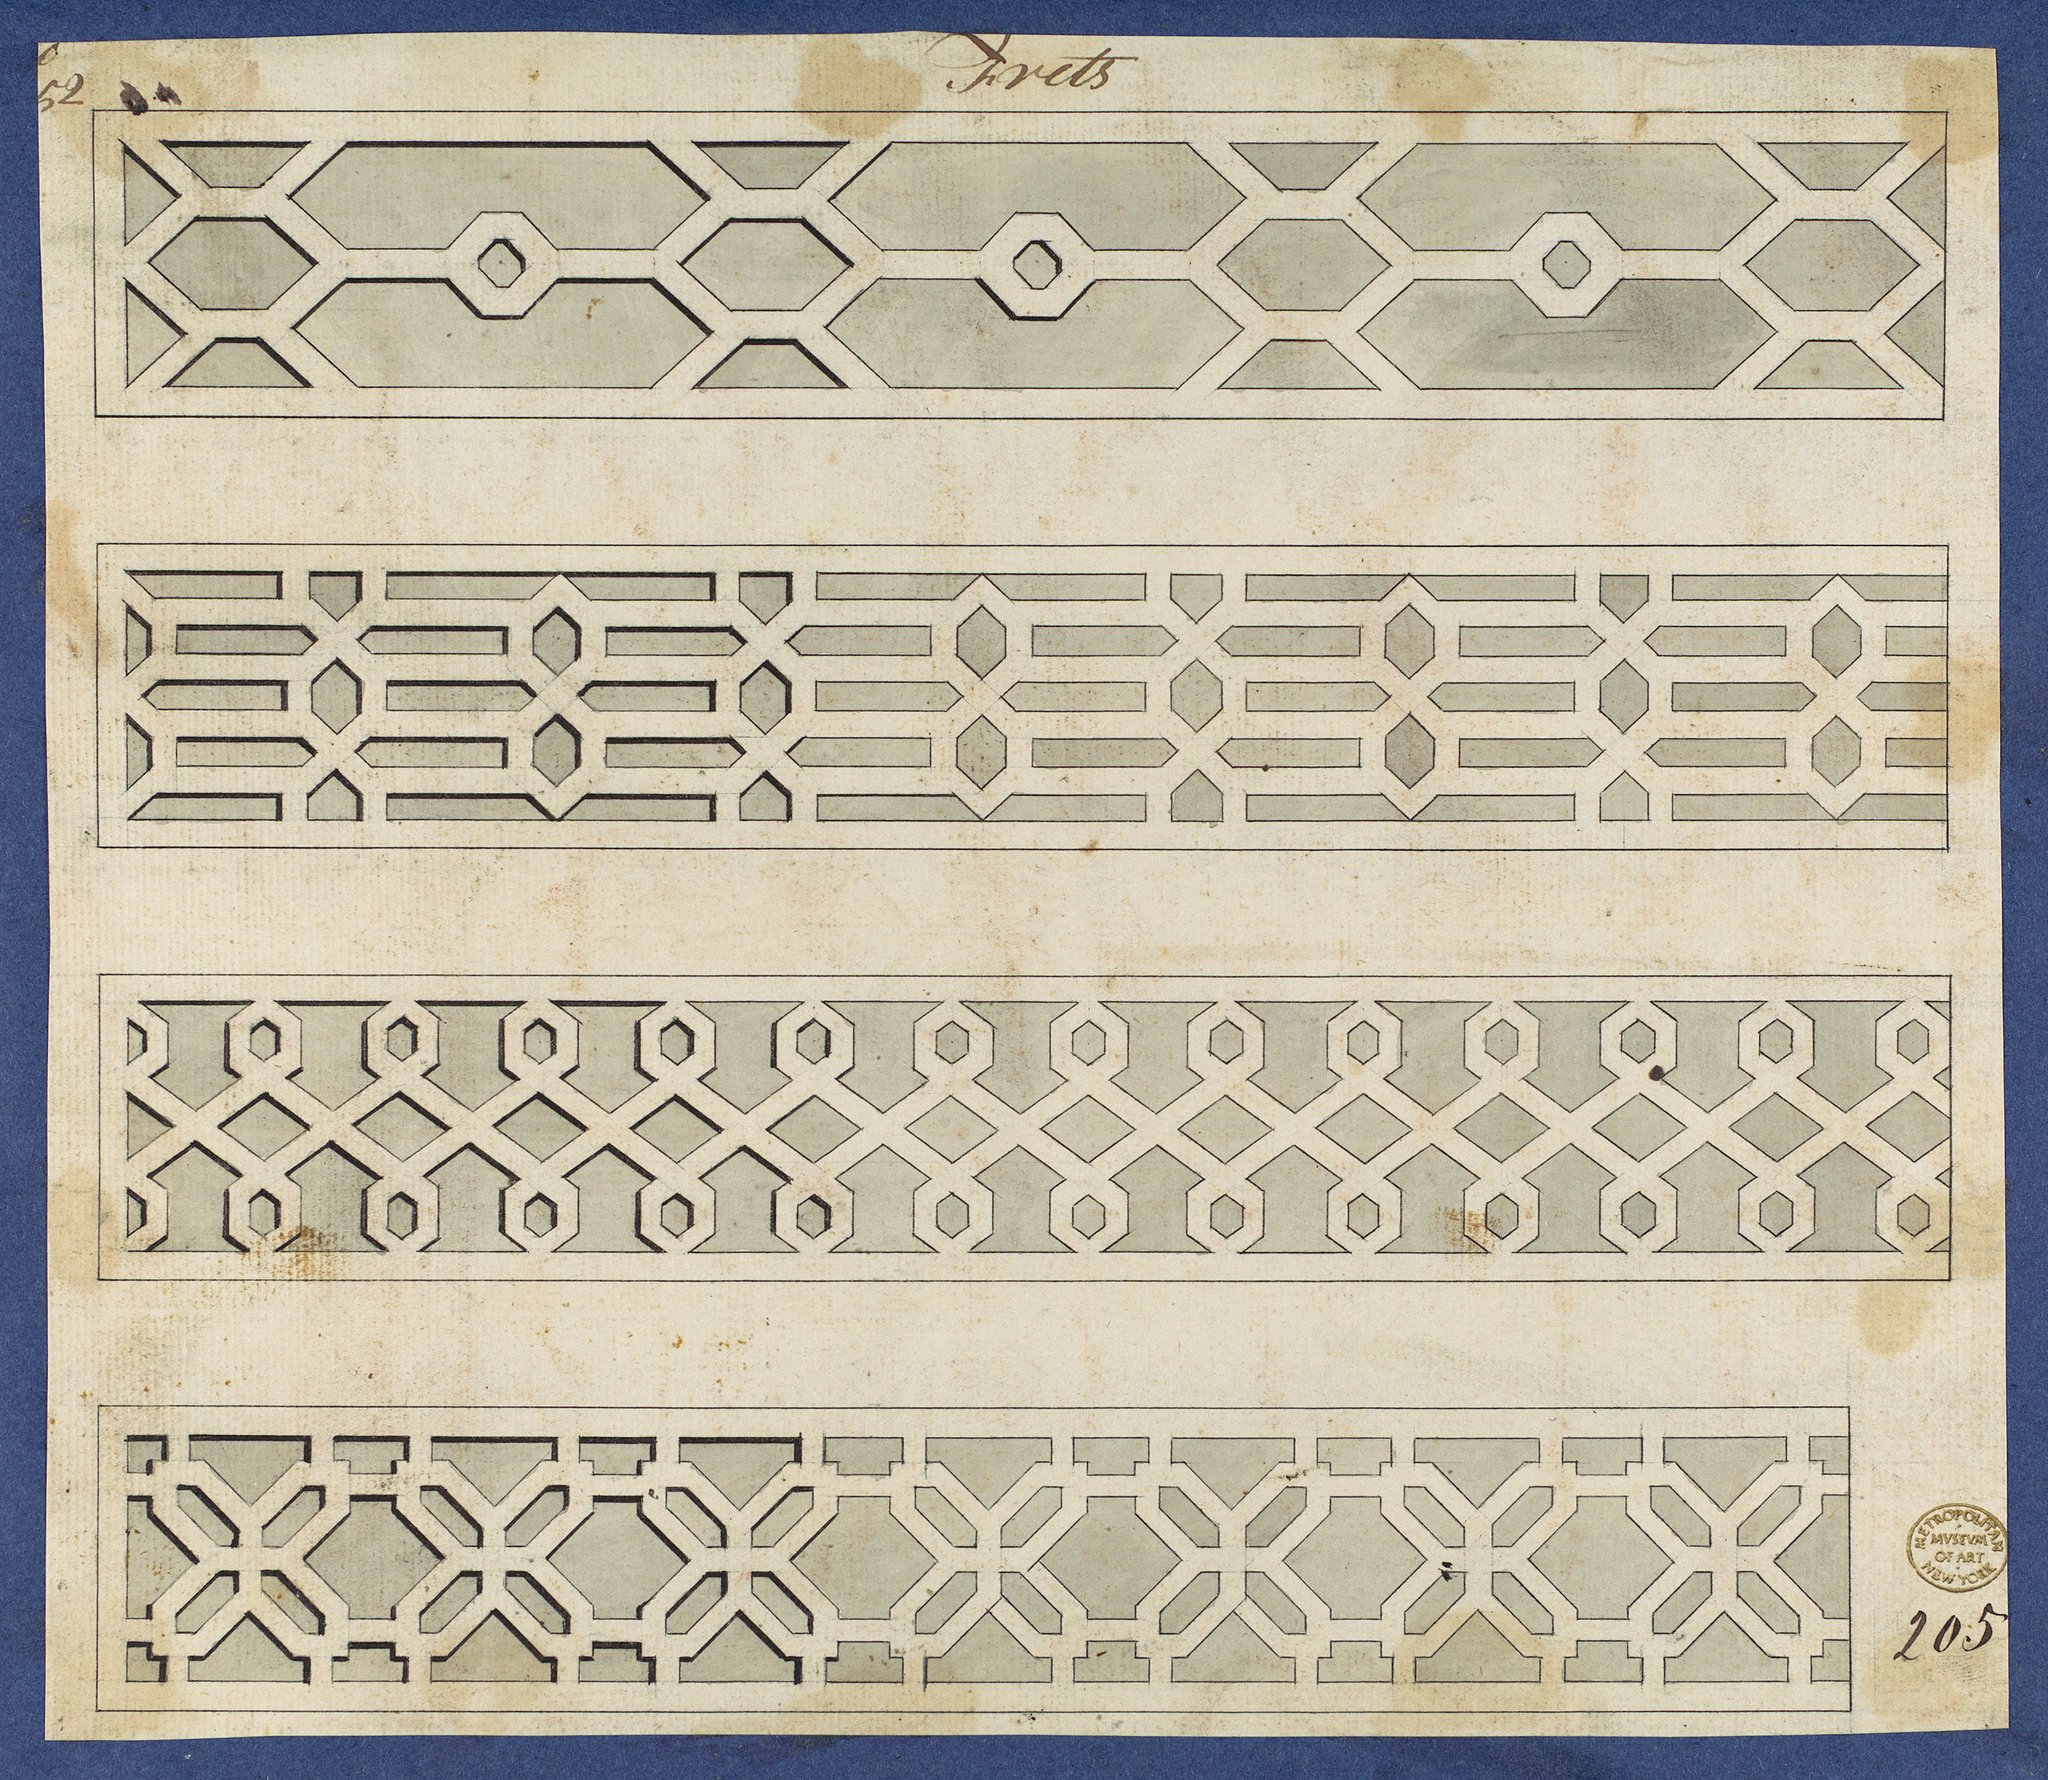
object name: drawing ornament architecture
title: Frets, from Chippendale Drawings, Vol. II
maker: thomas chippendale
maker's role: artist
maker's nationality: british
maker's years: 1718-1779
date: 1754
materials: ink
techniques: wash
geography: london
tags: ornament